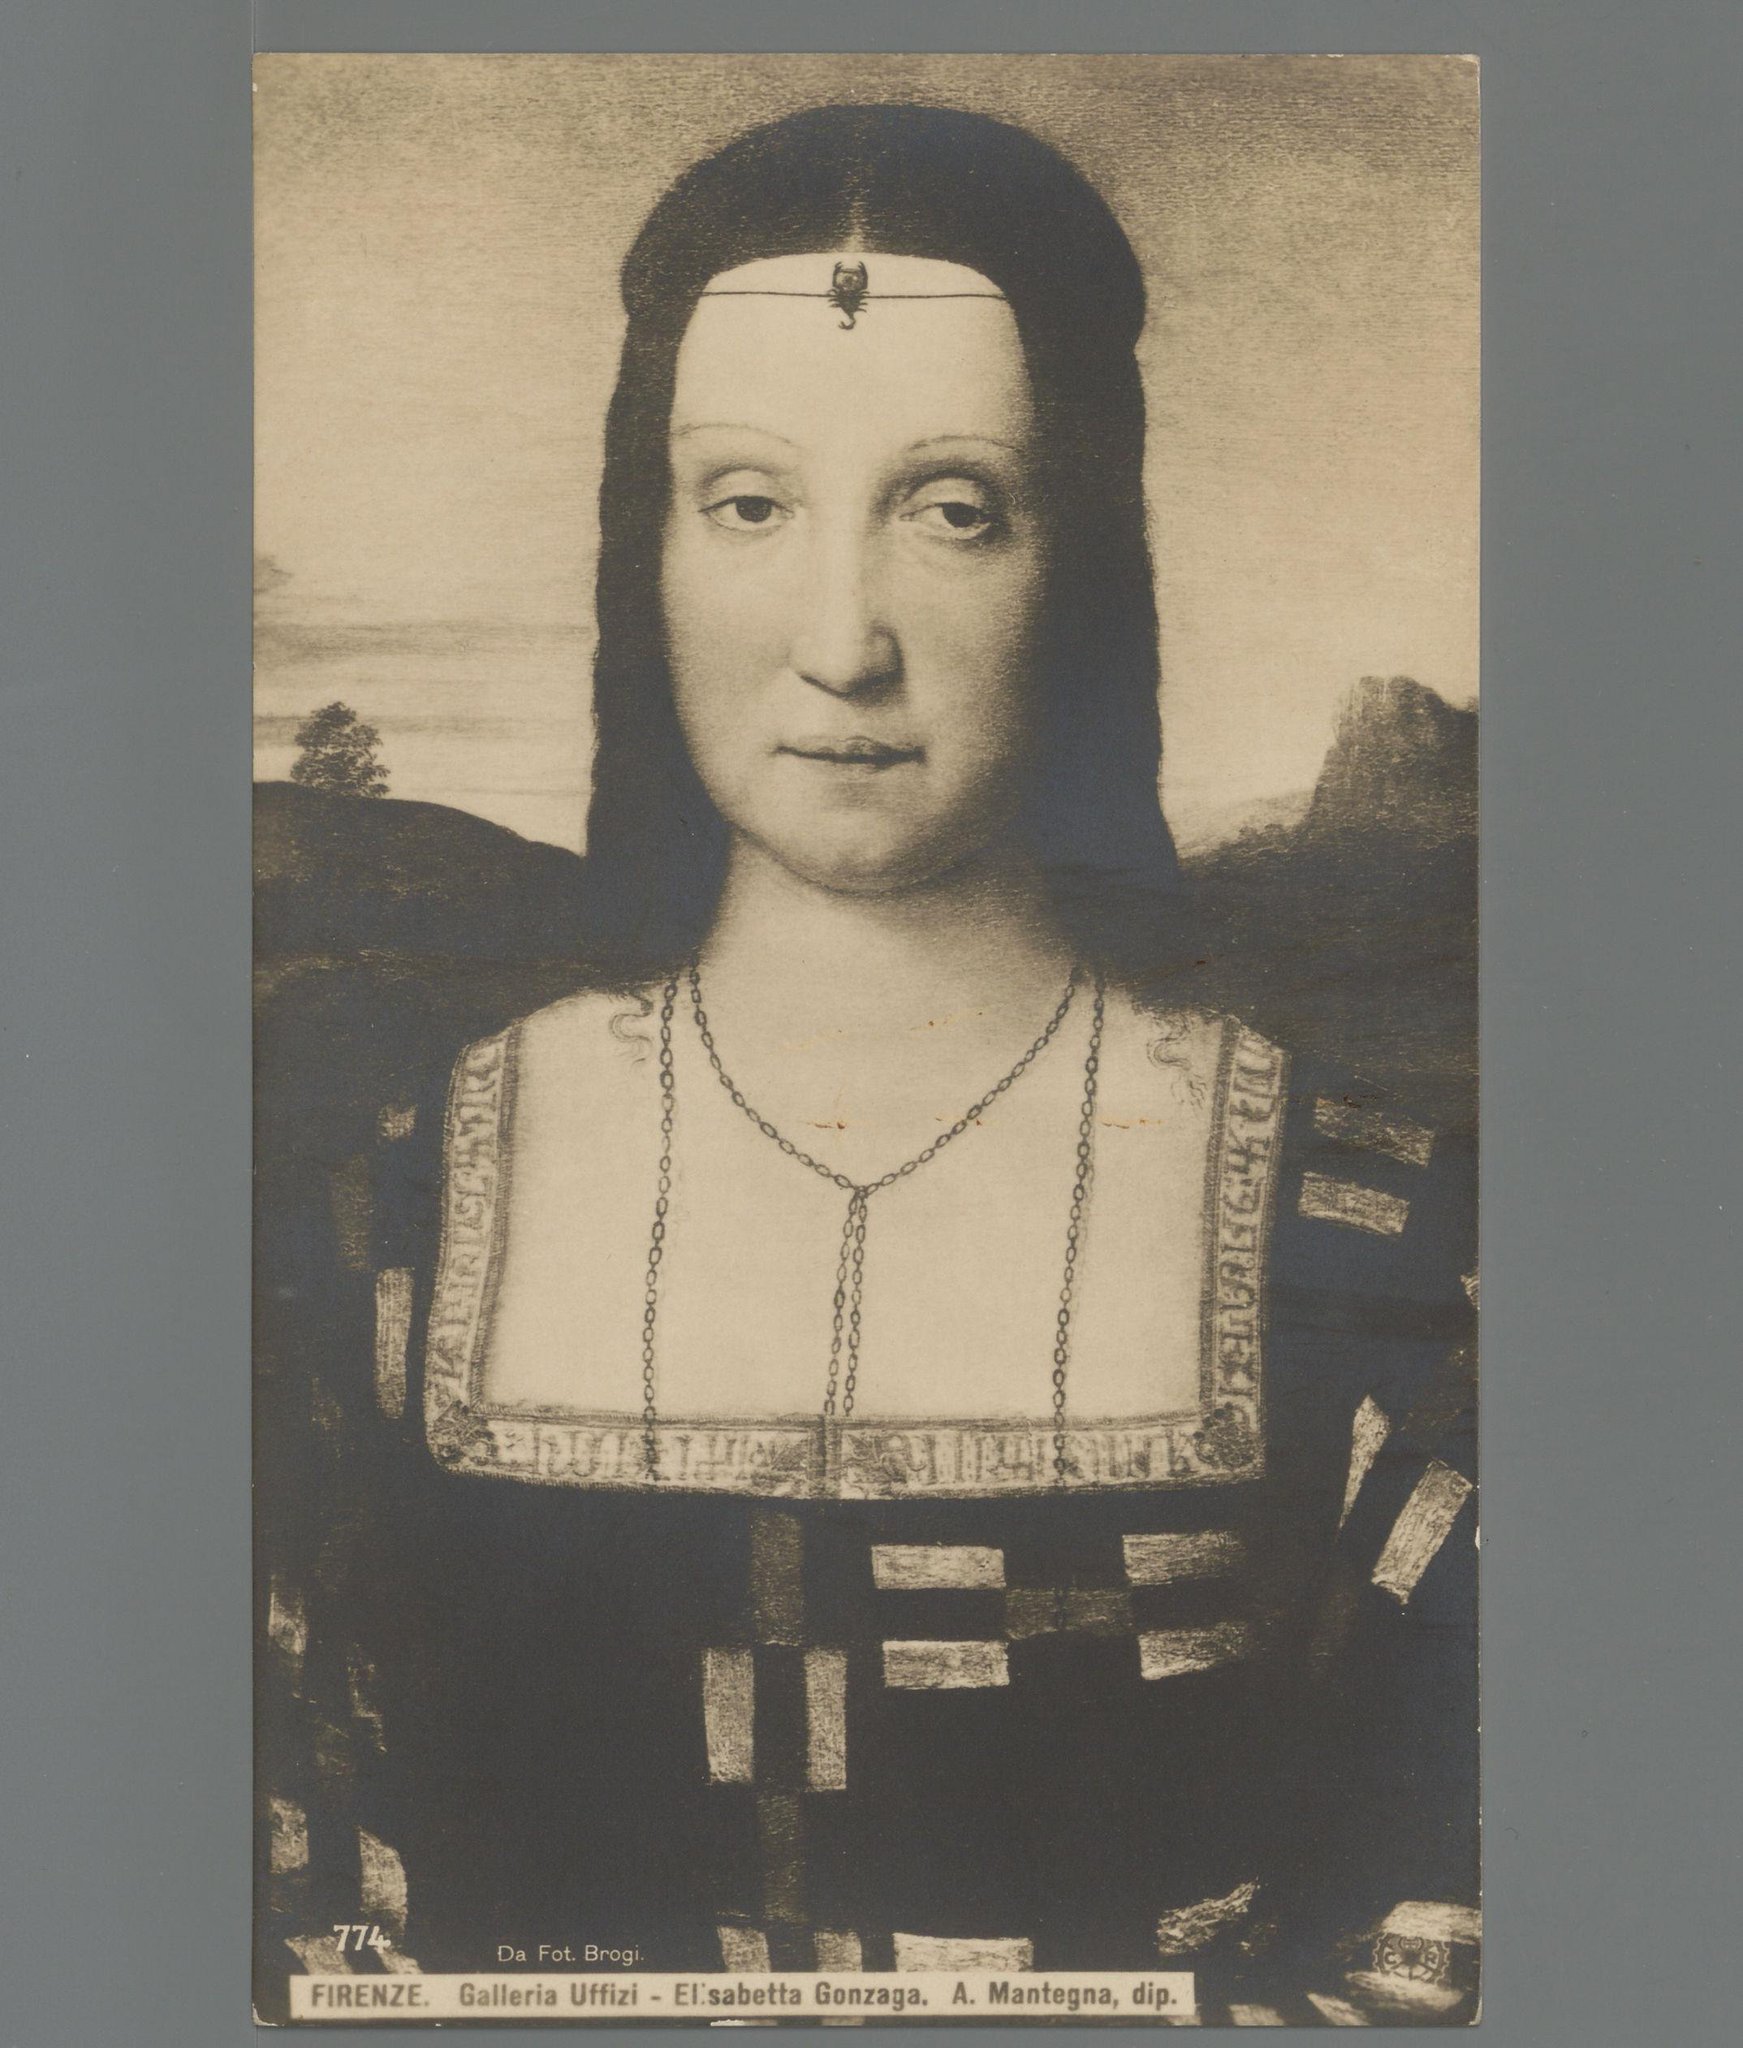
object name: ansichtkaart, prentbriefkaart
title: Firenze. Galleria Uffizi. Elisabetta Gonzaga. A. Mantegna, dip.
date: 1906-1930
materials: photographic support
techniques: photography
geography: florence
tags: historical persons - bb - woman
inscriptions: collector's mark: ‘AFE v S’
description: De prentbriefkaart vermeldt dat Andrea Mantegna de schilder is van het afgebeelde schilderij. Inmiddels wordt het schilderij aan Rafael toegeschreven.